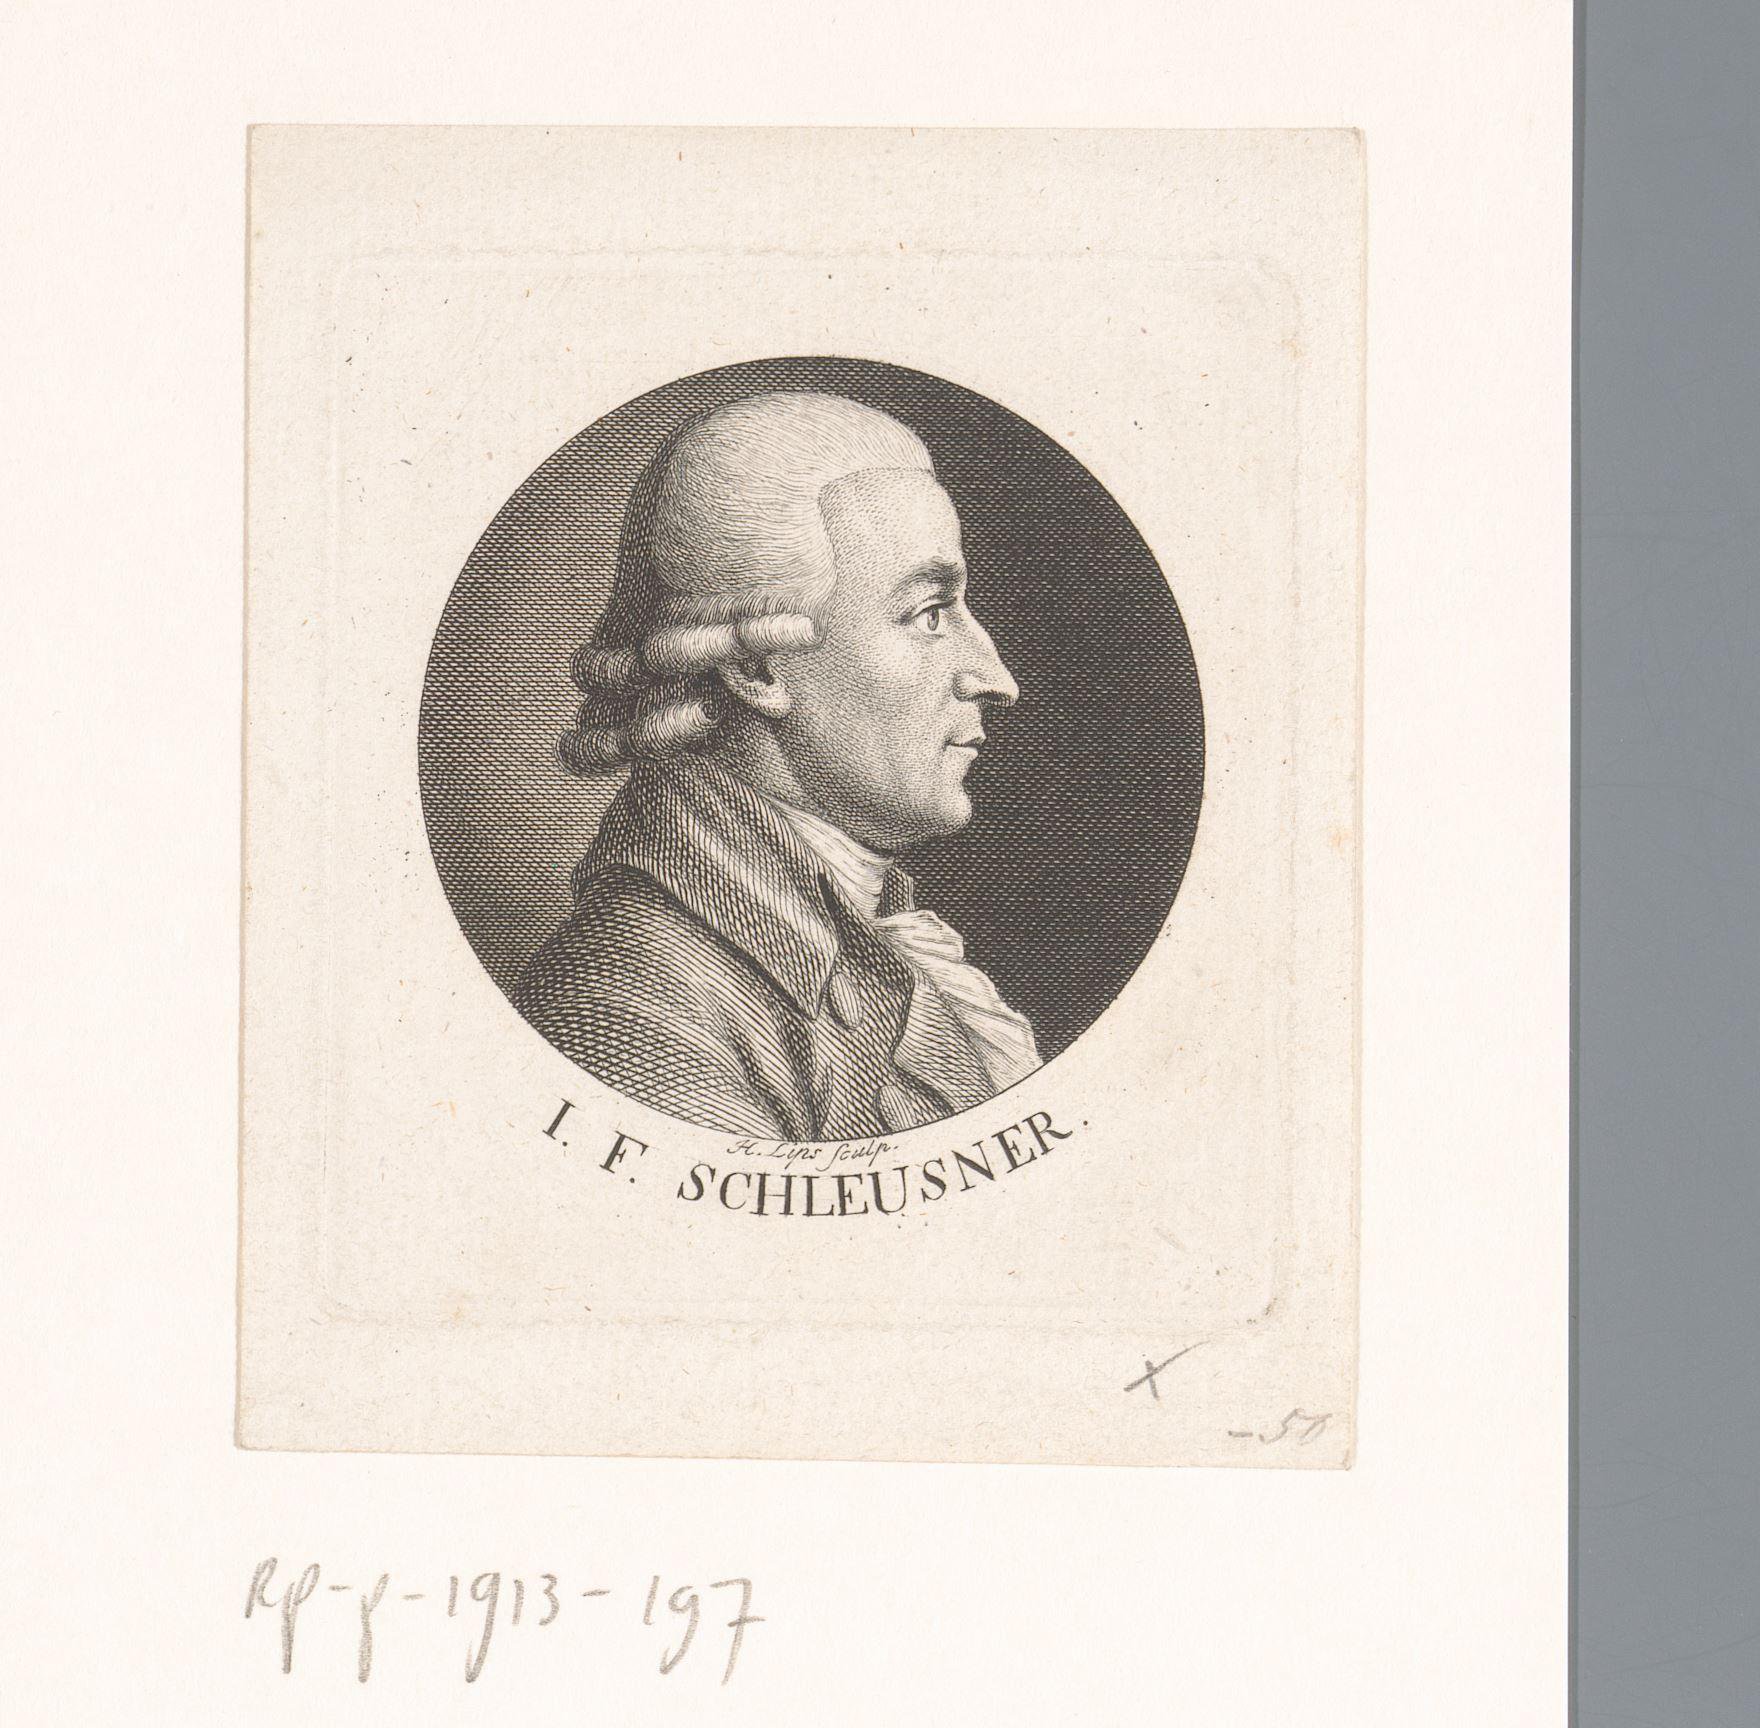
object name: print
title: Portret van Johann Friedrich Schleusner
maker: johann heinrich lips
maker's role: draughtsman, painter, print maker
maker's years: 1758-1817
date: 1768-1817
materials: paper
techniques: engraving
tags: theologian, historical persons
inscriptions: collector's mark: Lugt 2228